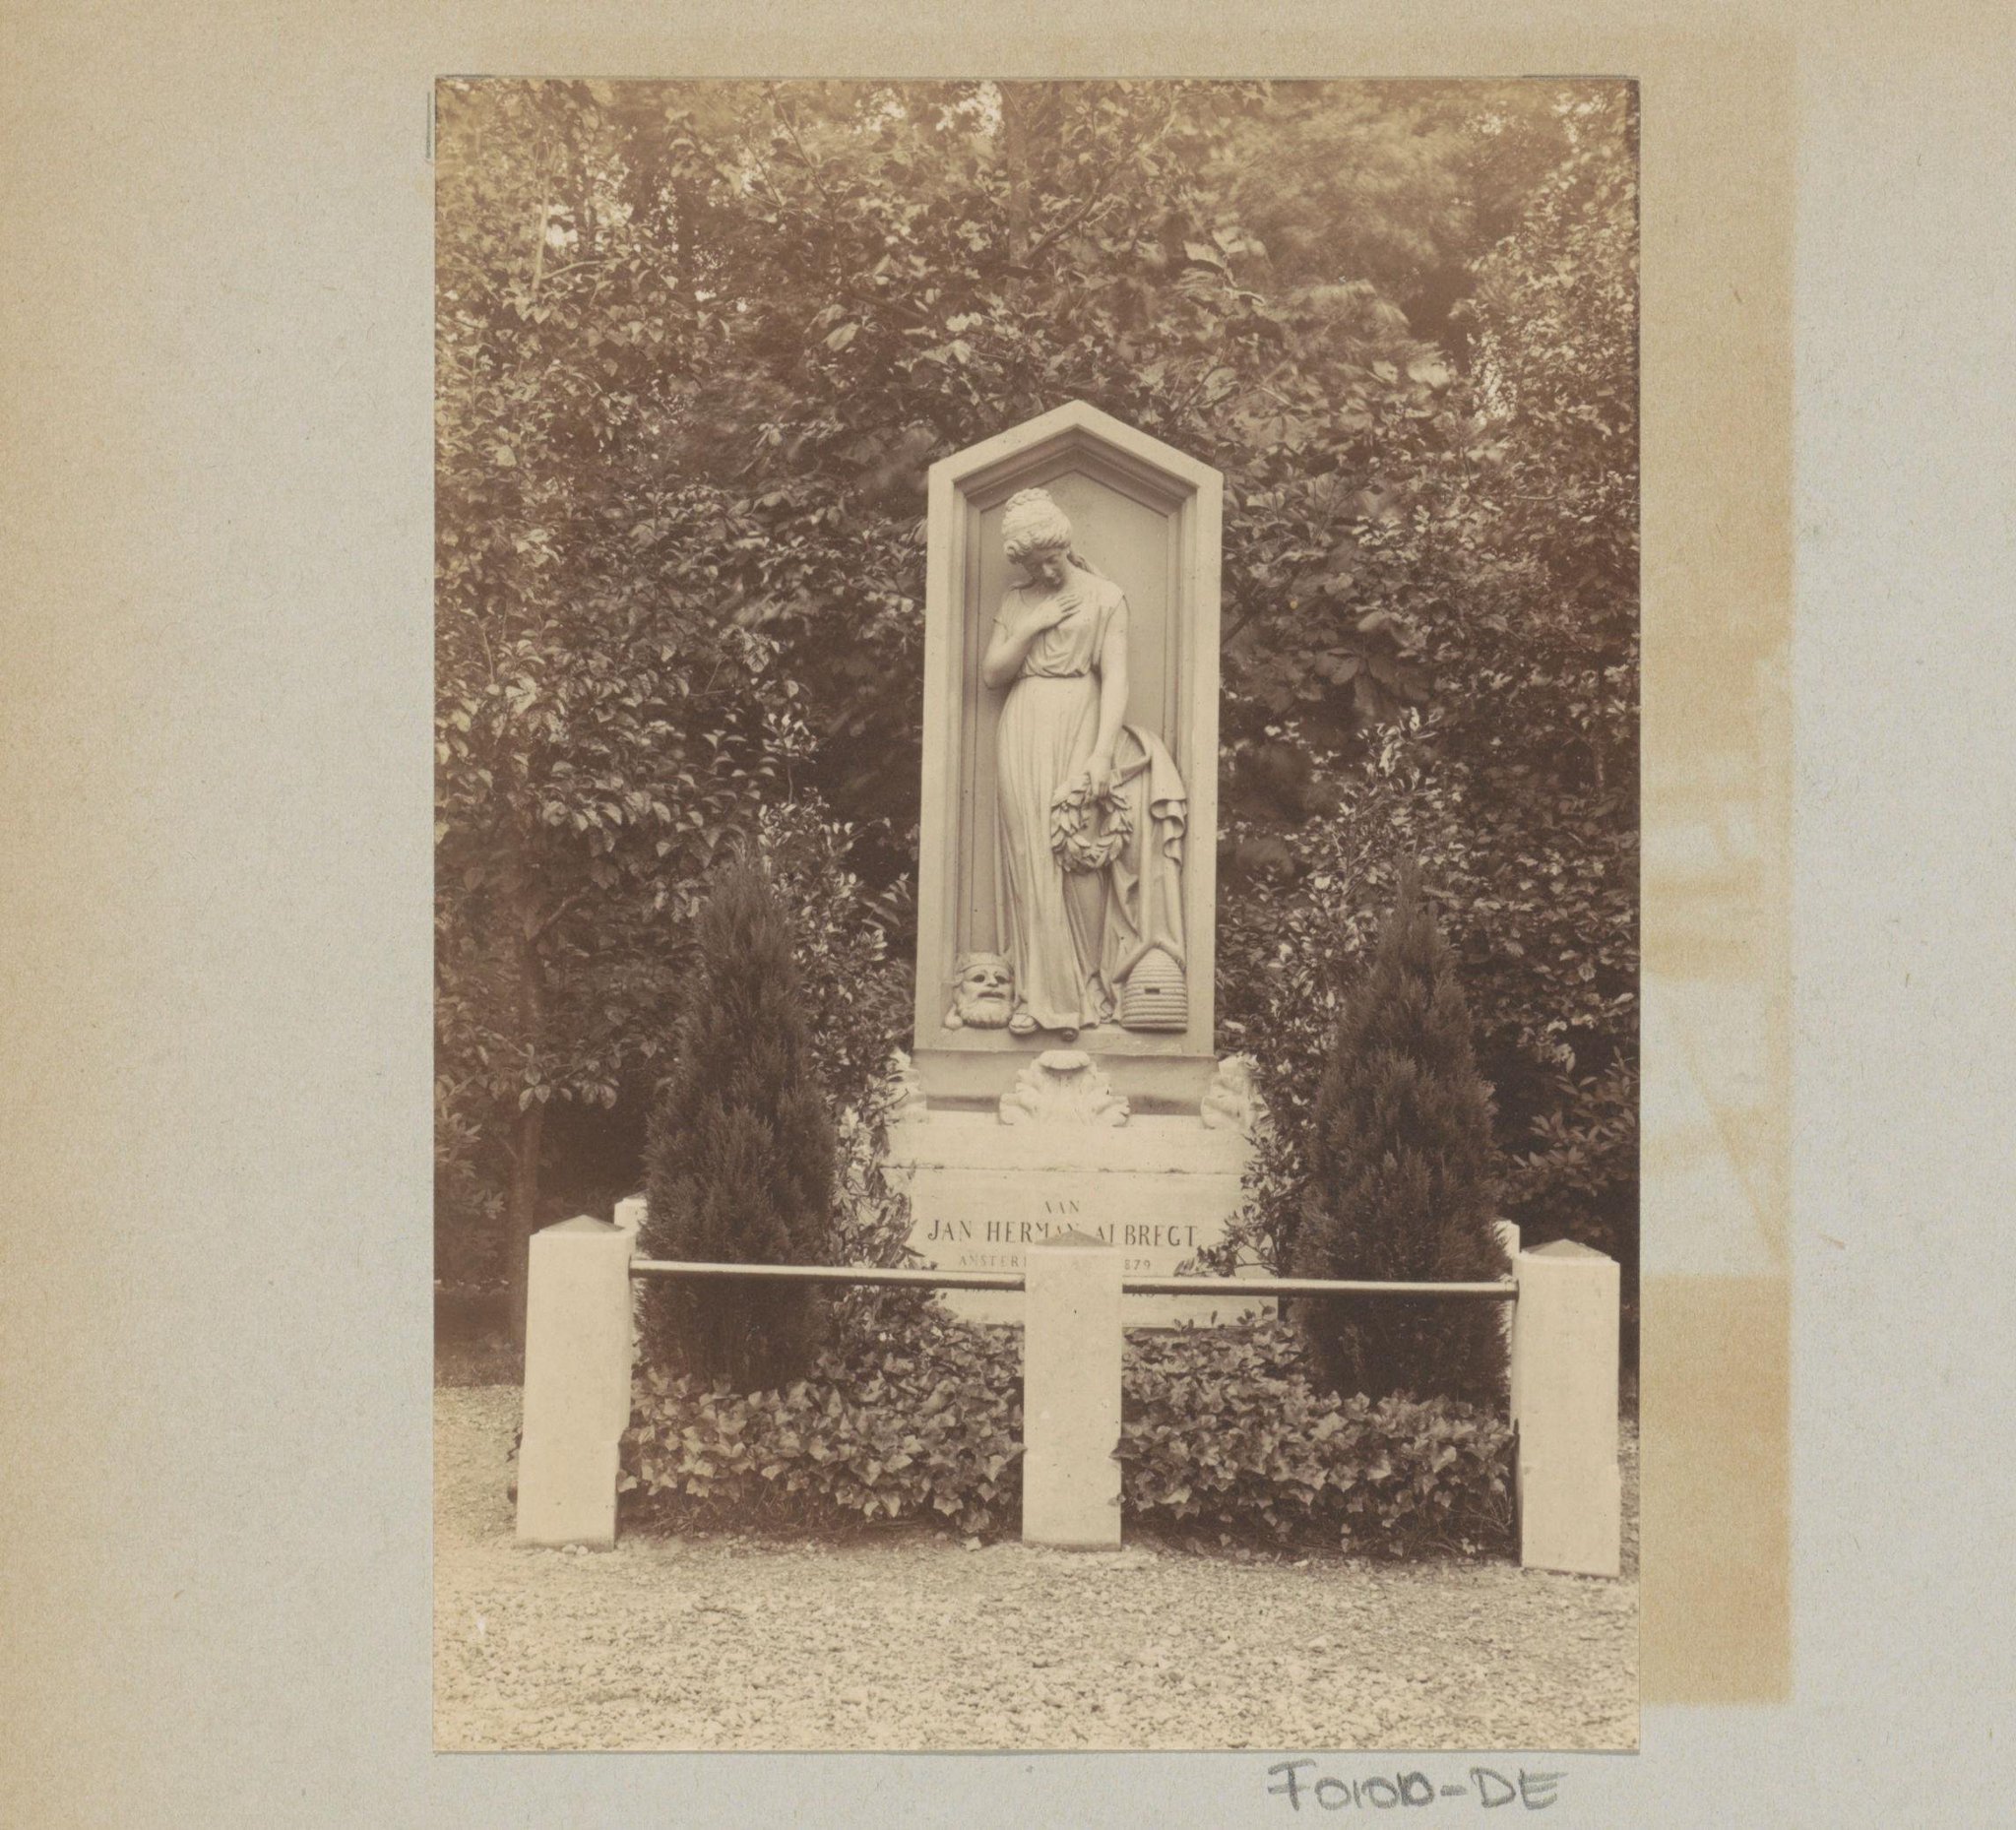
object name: photograph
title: Grafmonument van toneelspeler en schouwburgdirecteur Jan Herman Albregt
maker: Anonymous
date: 1900-1910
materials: photographic support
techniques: daylight paper print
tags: grave, tomb, amsterdam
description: Onderdeel van Familiealbum met onder meer foto's van Wijnhandel Kraaij & Co. Bordeaux-Amsterdam.